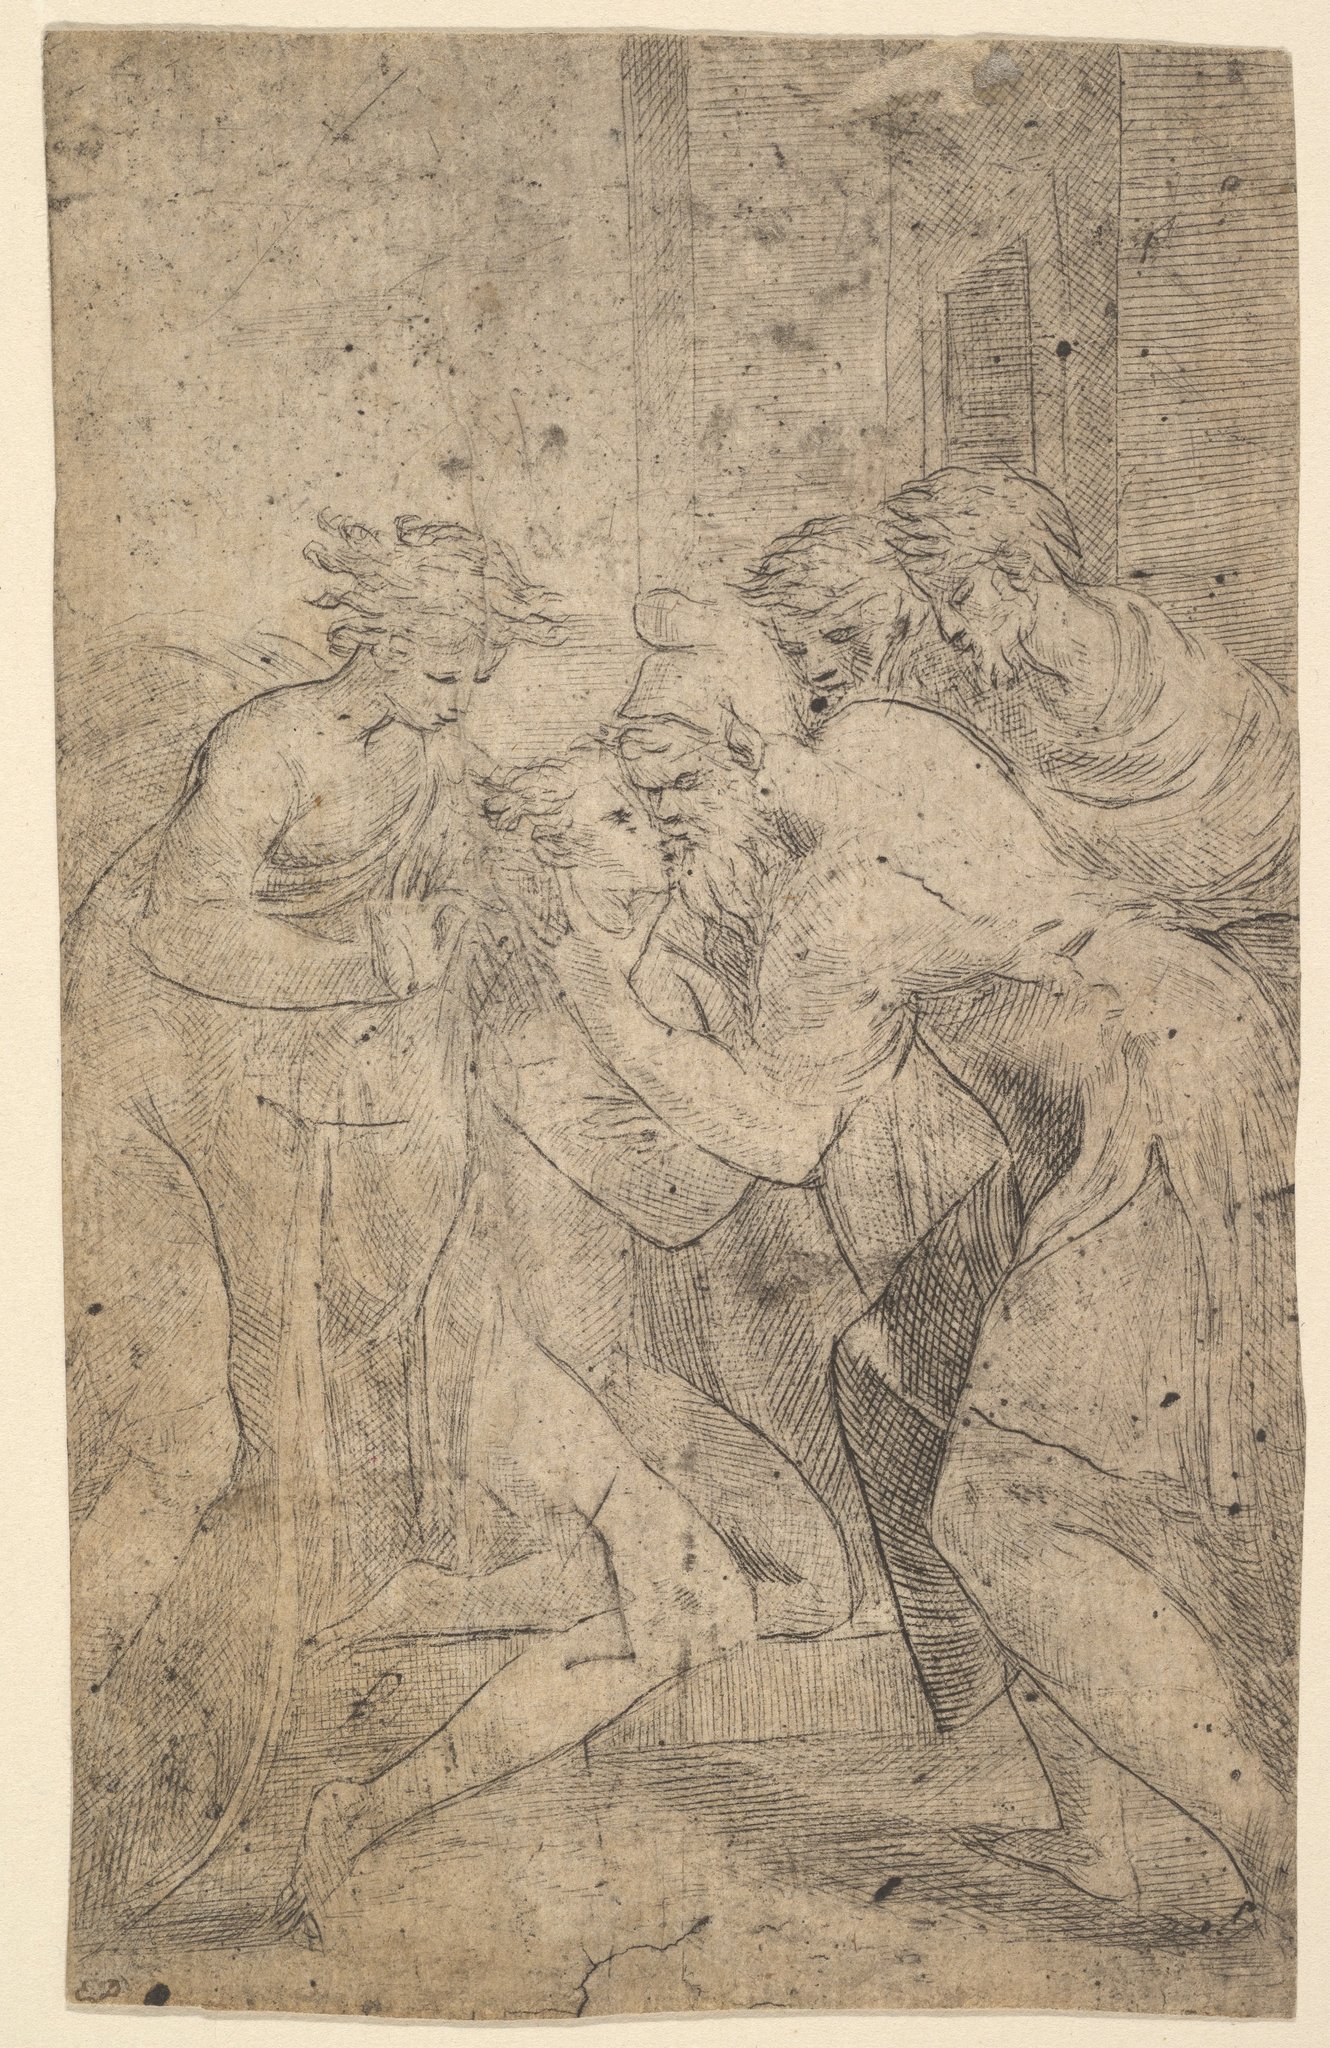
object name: print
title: The return of the prodigal son who falls at his father's feet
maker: andrea schiavone (andrea meldola)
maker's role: artist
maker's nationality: italian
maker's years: 1510-1563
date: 1536-1540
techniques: etching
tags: men